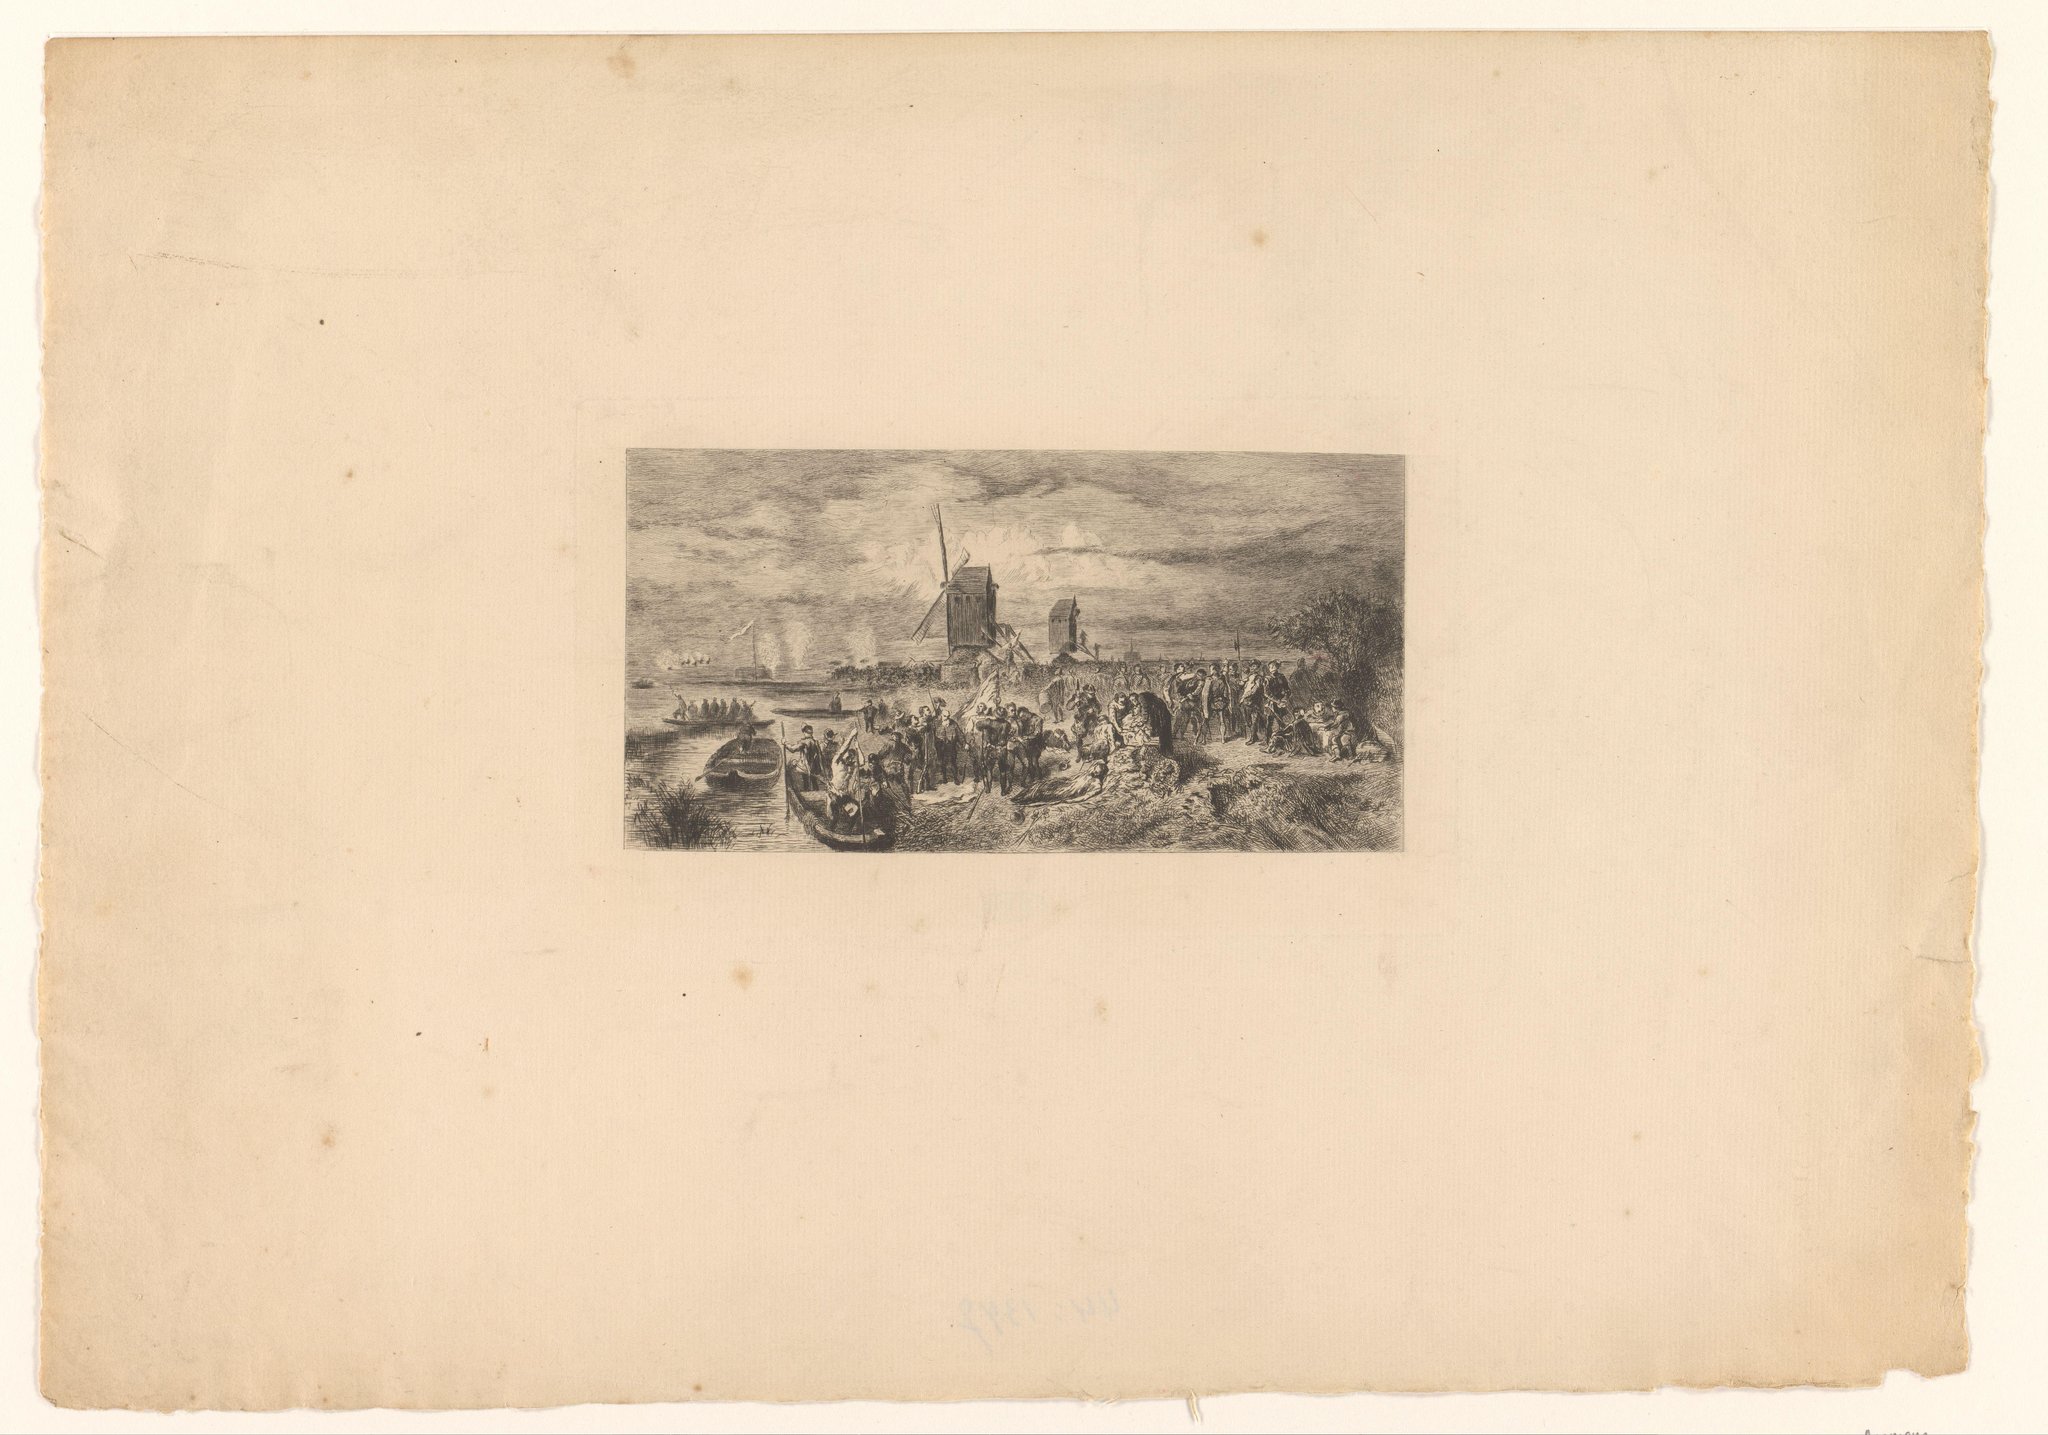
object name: print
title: Roeiboten, soldaten en gewonden bij een oever, mogelijk landing van de watergeuzen te Den Briel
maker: Anonymous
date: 1800-1899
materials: paper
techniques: etching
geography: netherlands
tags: medical aid and nursing of the sick and wounded, capture of city (after the siege), rowing-boat, canoe, etc., windmill in landscape, brielle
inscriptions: collector's mark: Lugt 2228